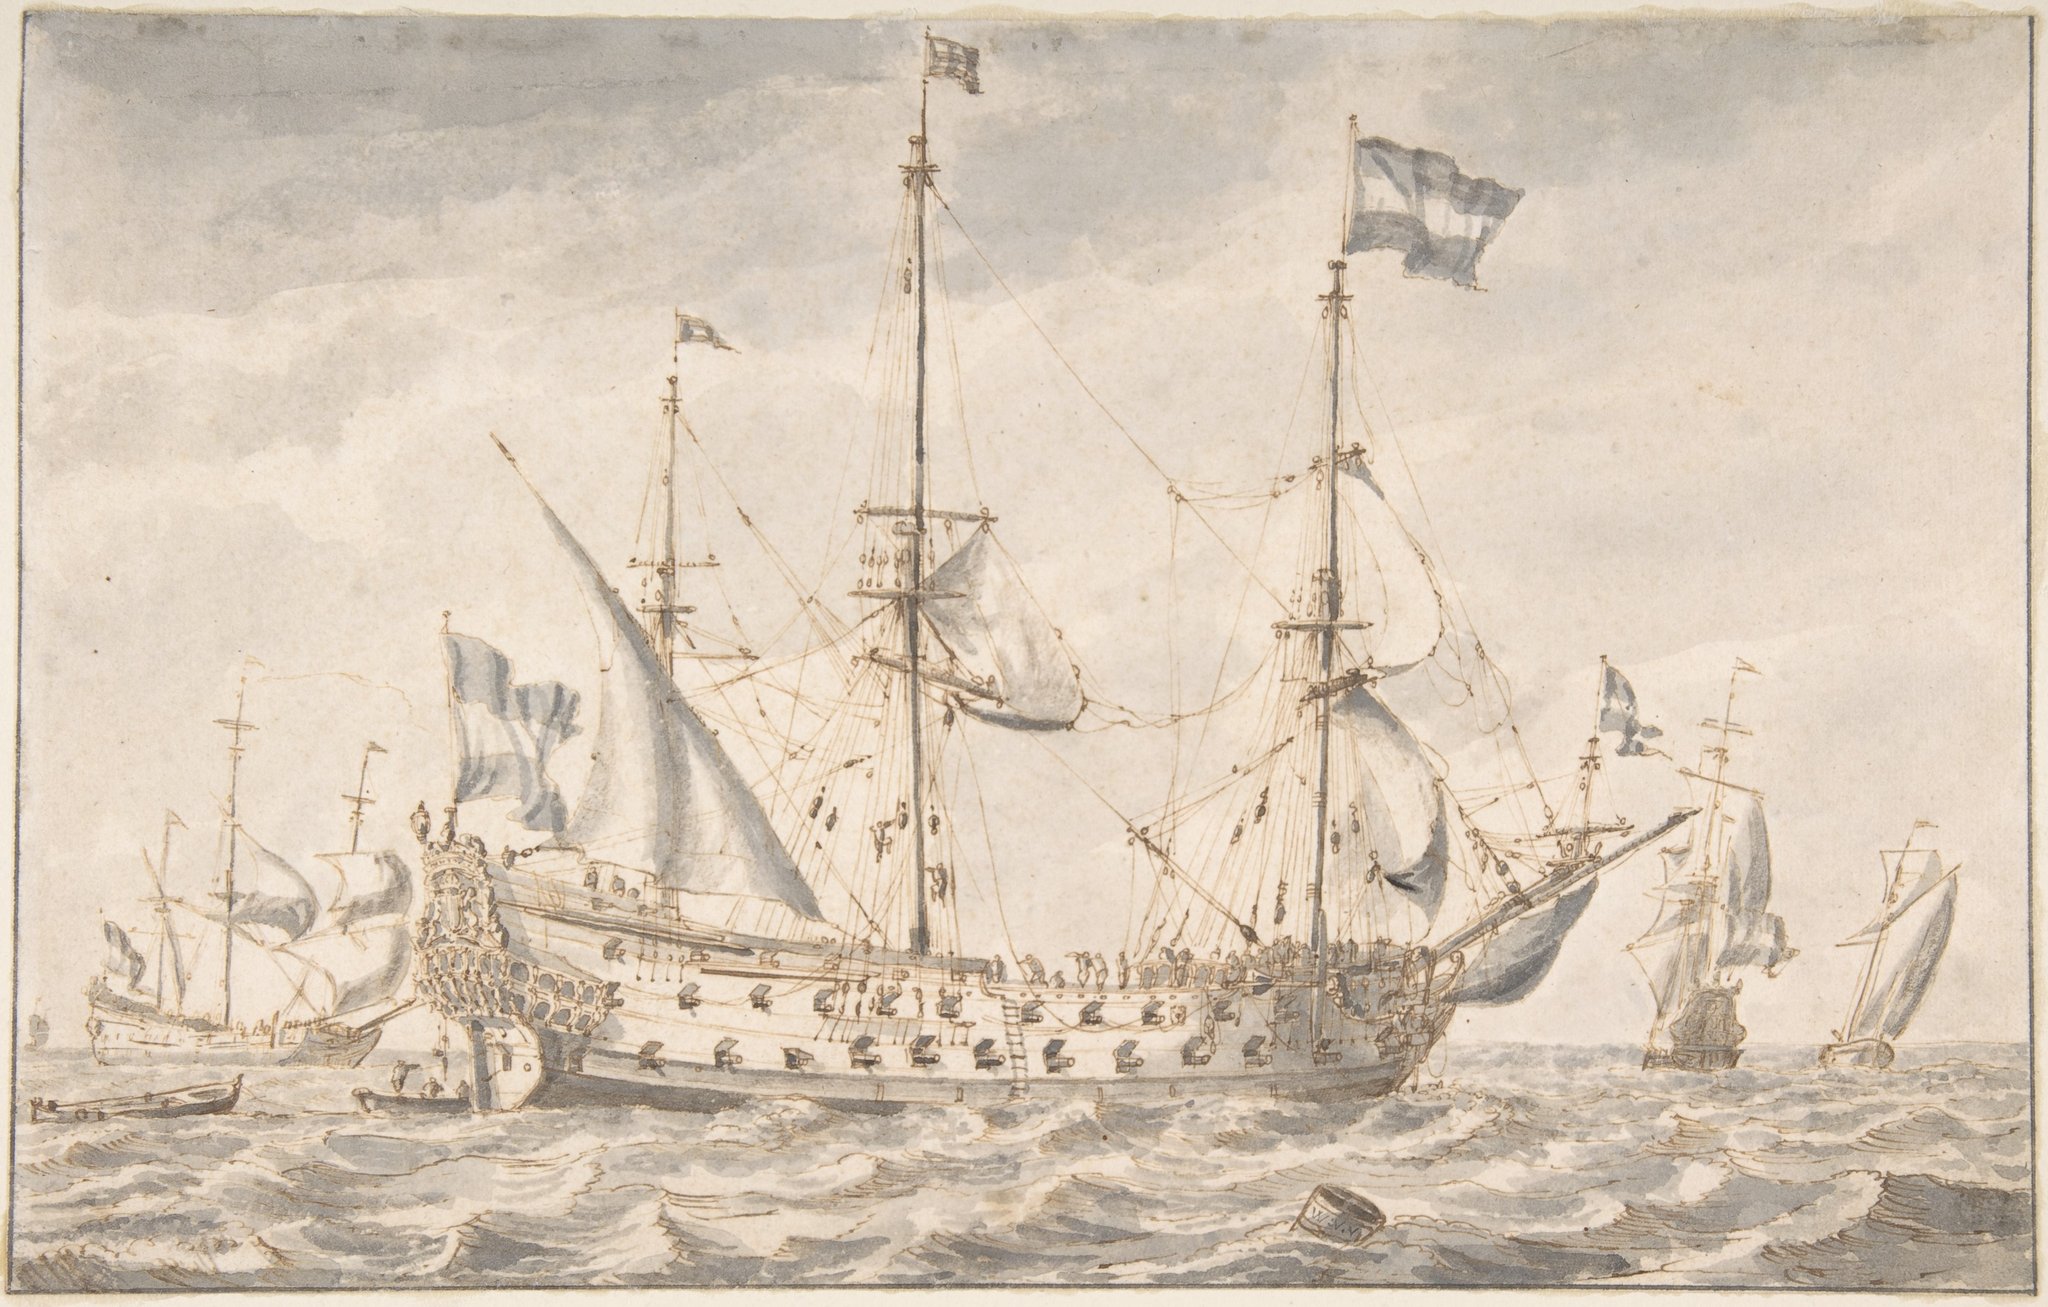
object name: drawing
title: Dutch Men Of War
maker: willem van de velde (i)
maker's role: artist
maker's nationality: dutch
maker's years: 1611-1693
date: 1601-1700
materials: ink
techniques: brush, pen, wash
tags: ships